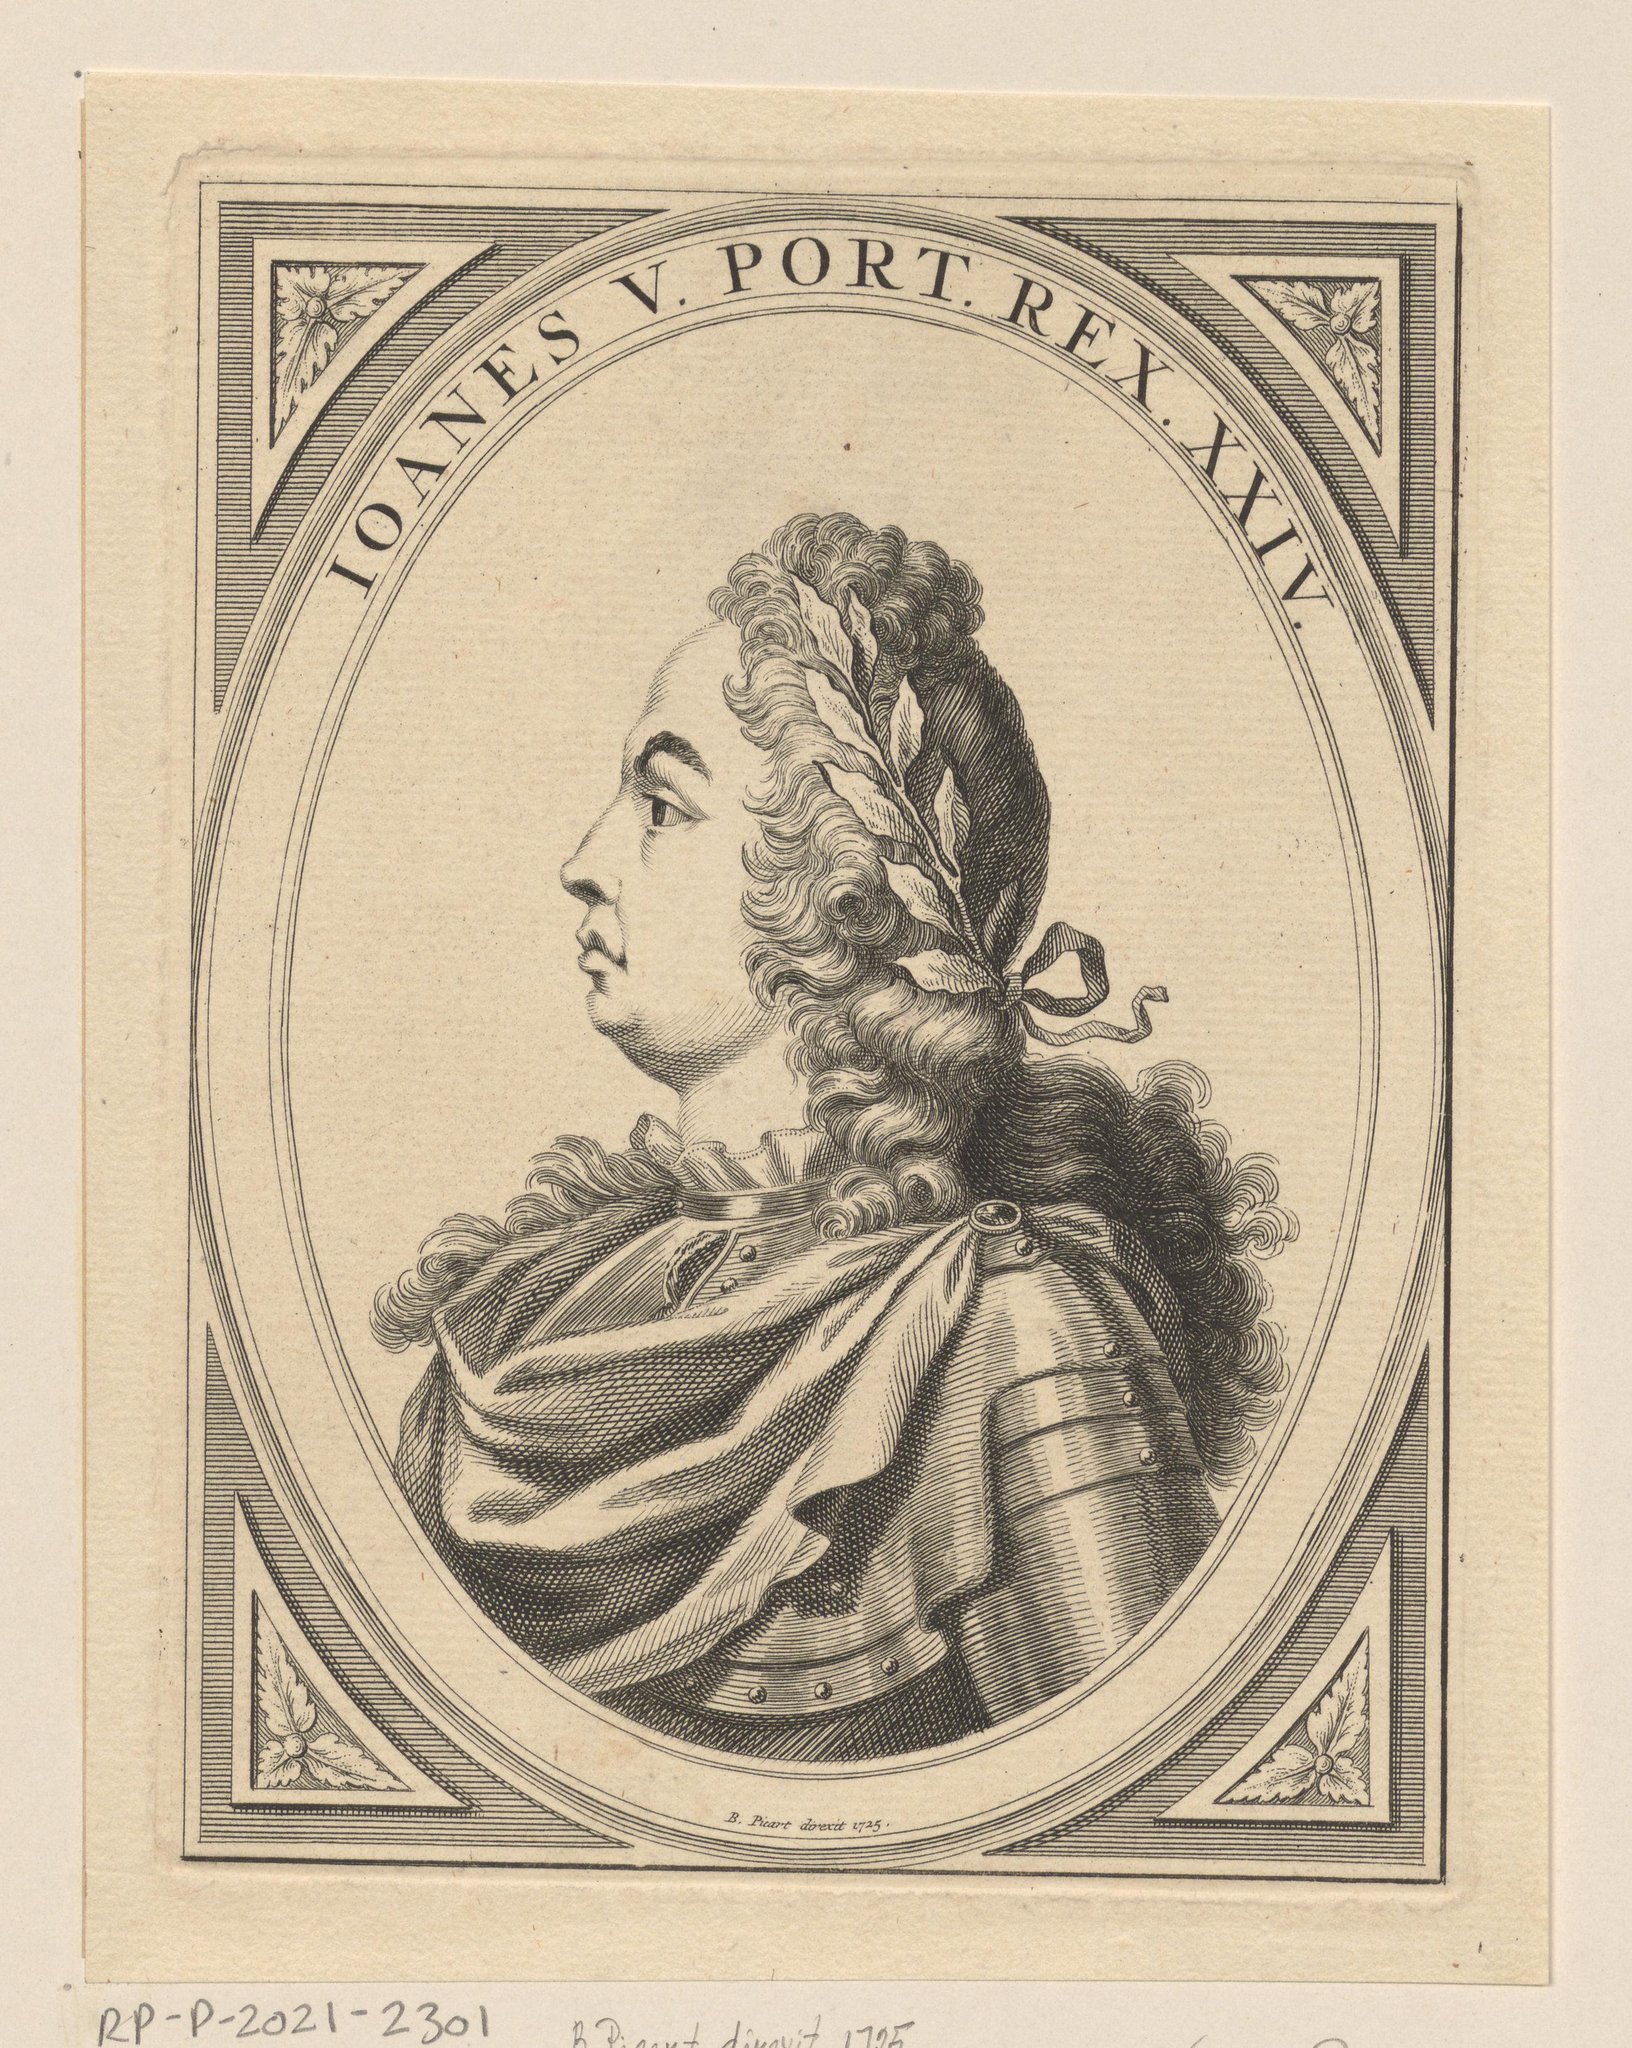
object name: print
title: Portret van Johan V, koning van Portugal op 24-jarige leeftijd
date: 1725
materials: paper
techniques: engraving, etching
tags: historical persons, king